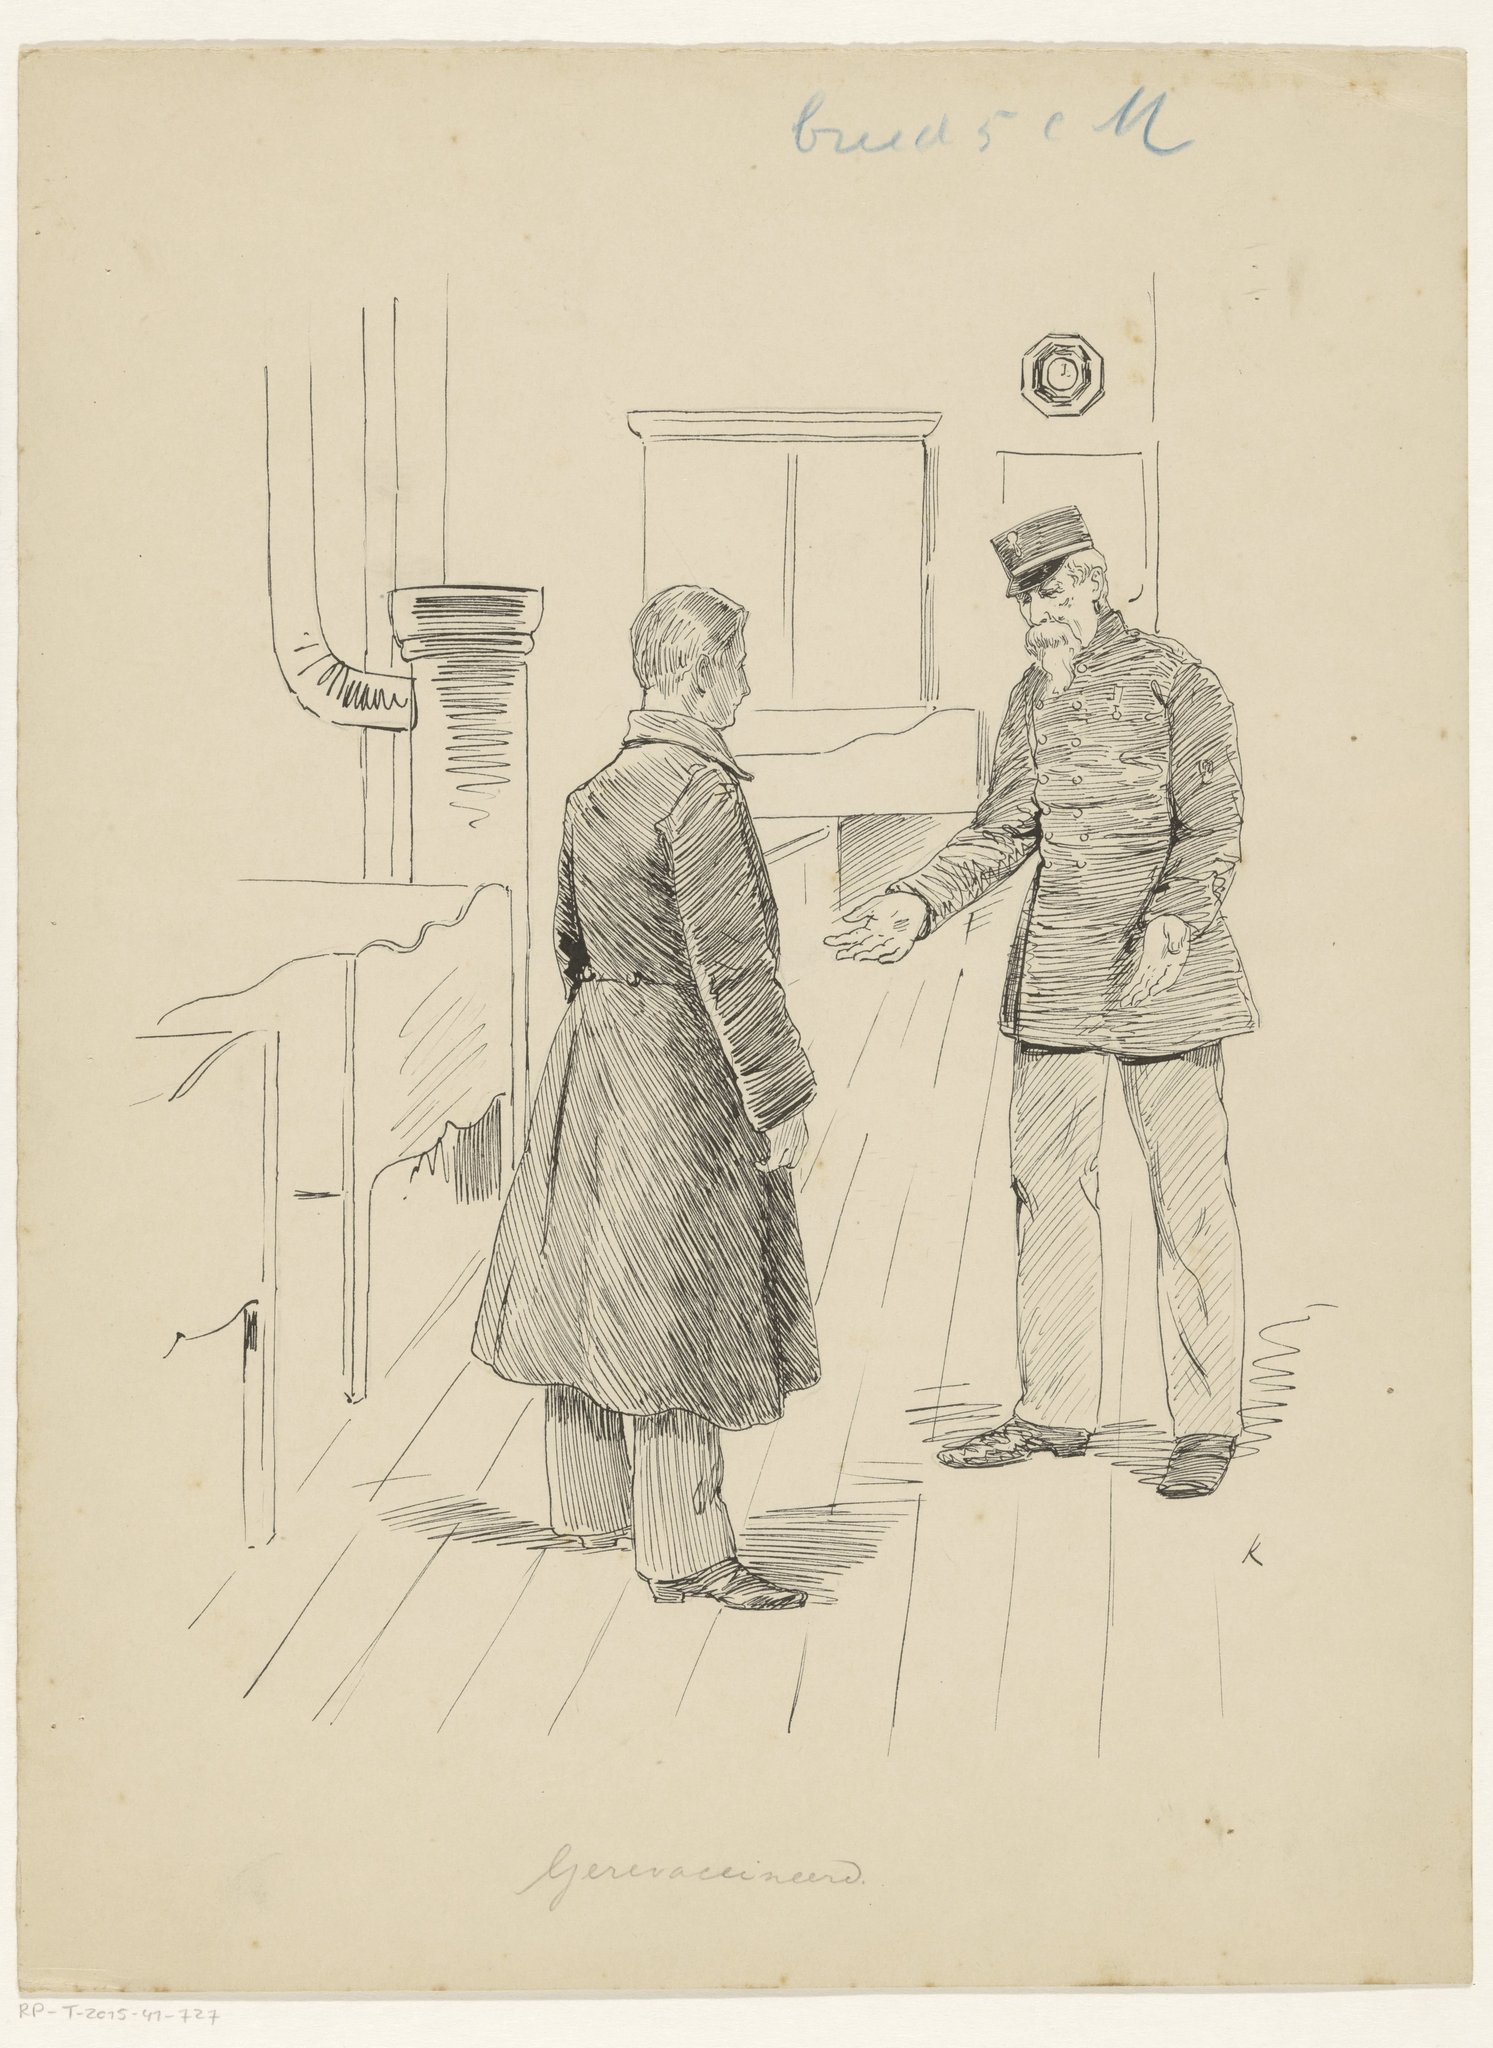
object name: drawing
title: Man in overjas en een militair in een interieur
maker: heinrich m. krabbé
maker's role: draughtsman, print maker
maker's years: 1868-1931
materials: ink, paper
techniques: pen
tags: the soldier; the soldier's life, ward; room (in hospital)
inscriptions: annotation: ‘Gerevaccineerd.’, collector's mark: Lugt 2228, signature: ‘K’, :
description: De twee mannen staan tegenover elkaar in een ruimte waar langs de wand een rij bedden staat, mogelijk een ziekenzaal. De man in militair uniform houdt de palmen van zijn handen op.